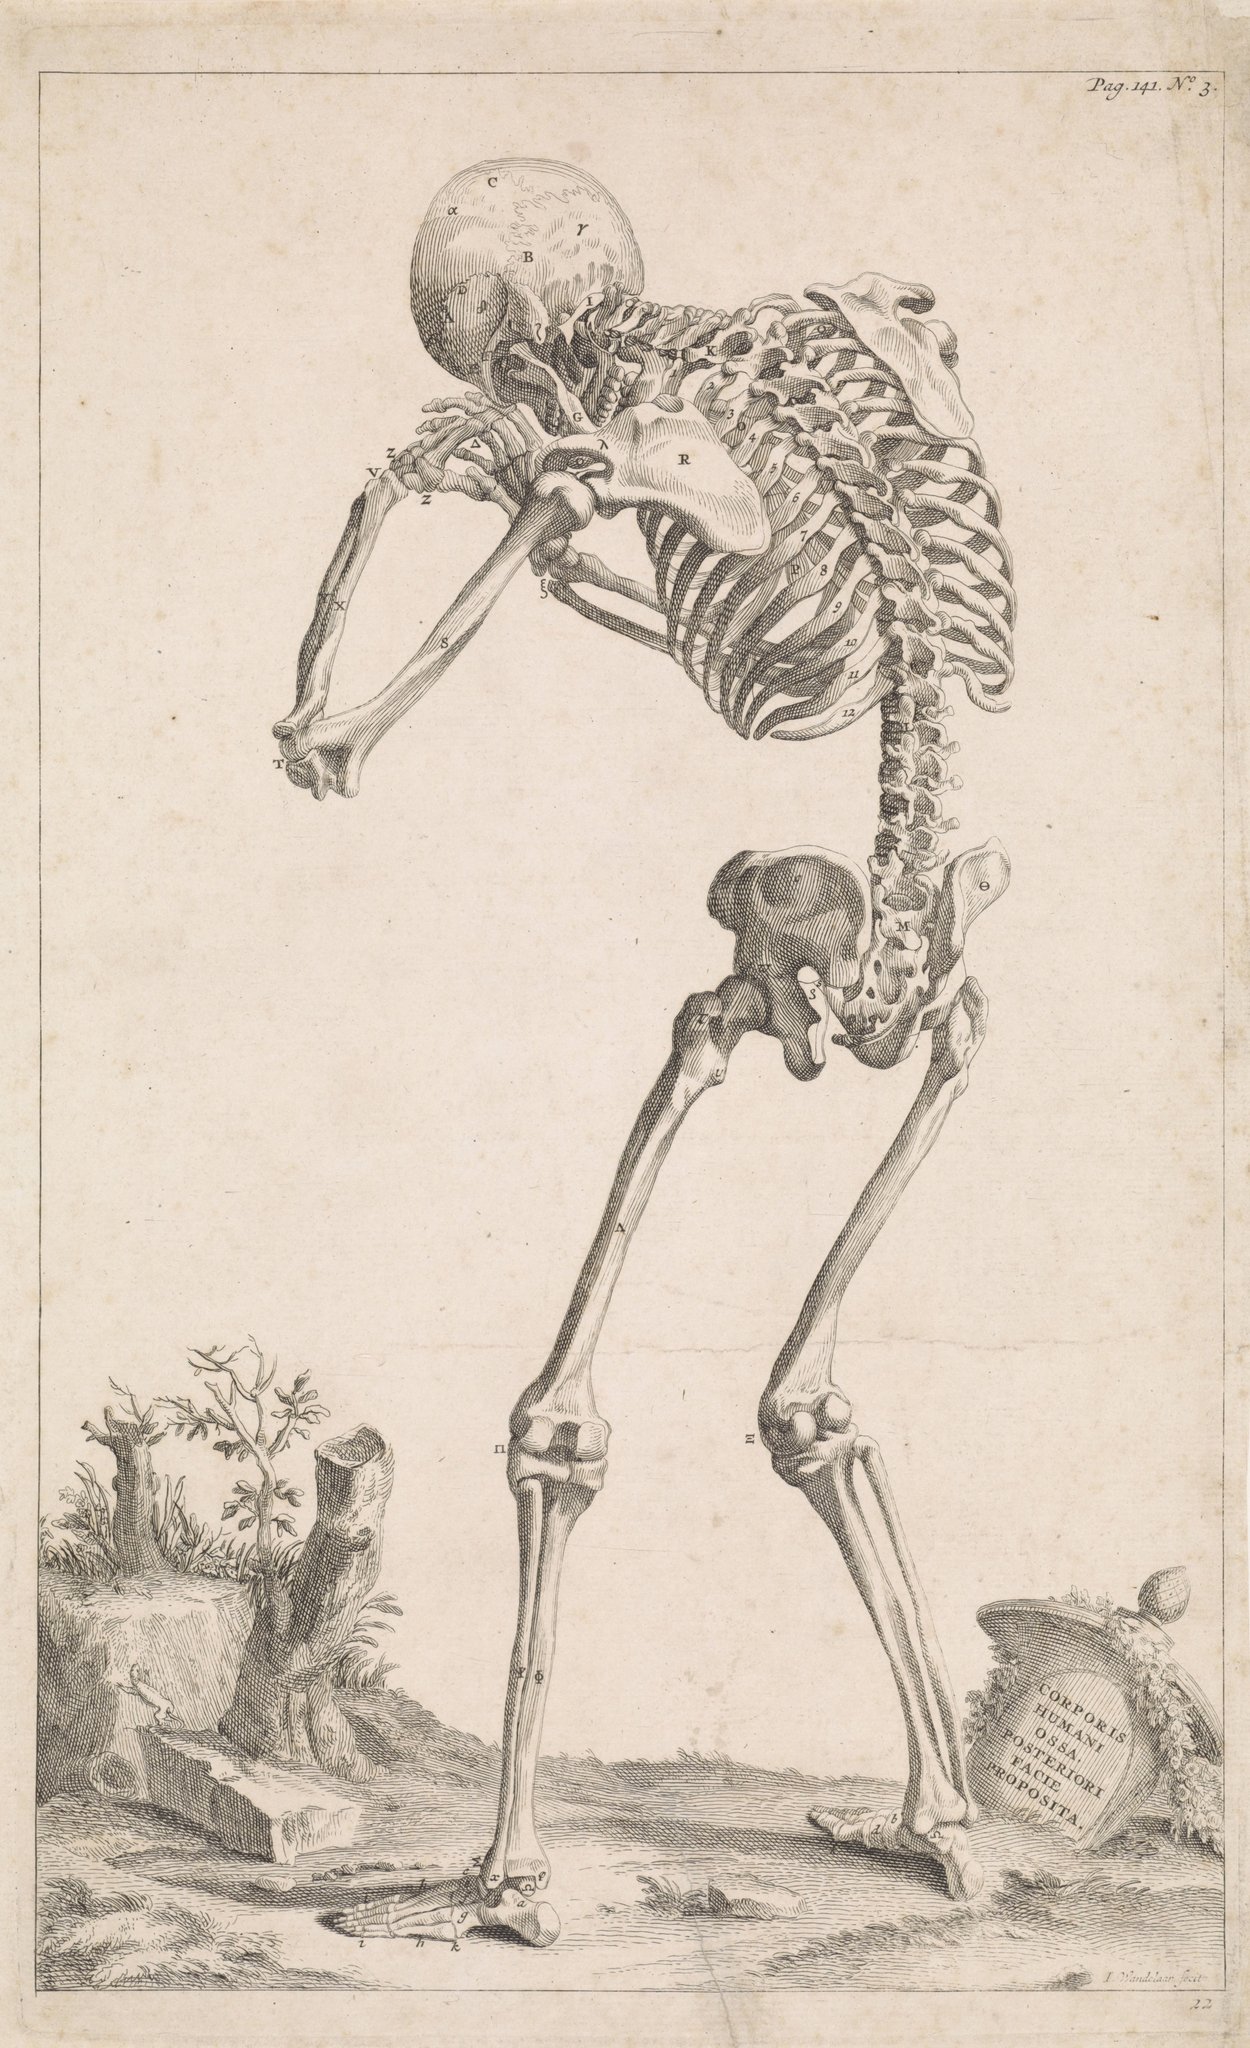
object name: book illustration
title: Landschap met skelet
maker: jan wandelaar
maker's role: draughtsman, print maker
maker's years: 1690-1759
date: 1725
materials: paper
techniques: engraving, etching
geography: northern netherlands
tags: (human) skeleton (+ back view)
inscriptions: collector's mark: Lugt 2233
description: Prent gebruikt als illustratie in: Vesalius, Andreas. [Bewerkt door] Herman Boerhaave en Bernhard Siegfried Albinus. Opera omnia anatomica & chirurgica, p. 141. Leiden: Johannes Du Vivié, Johannes en Hermanus Verbeek, 1725.